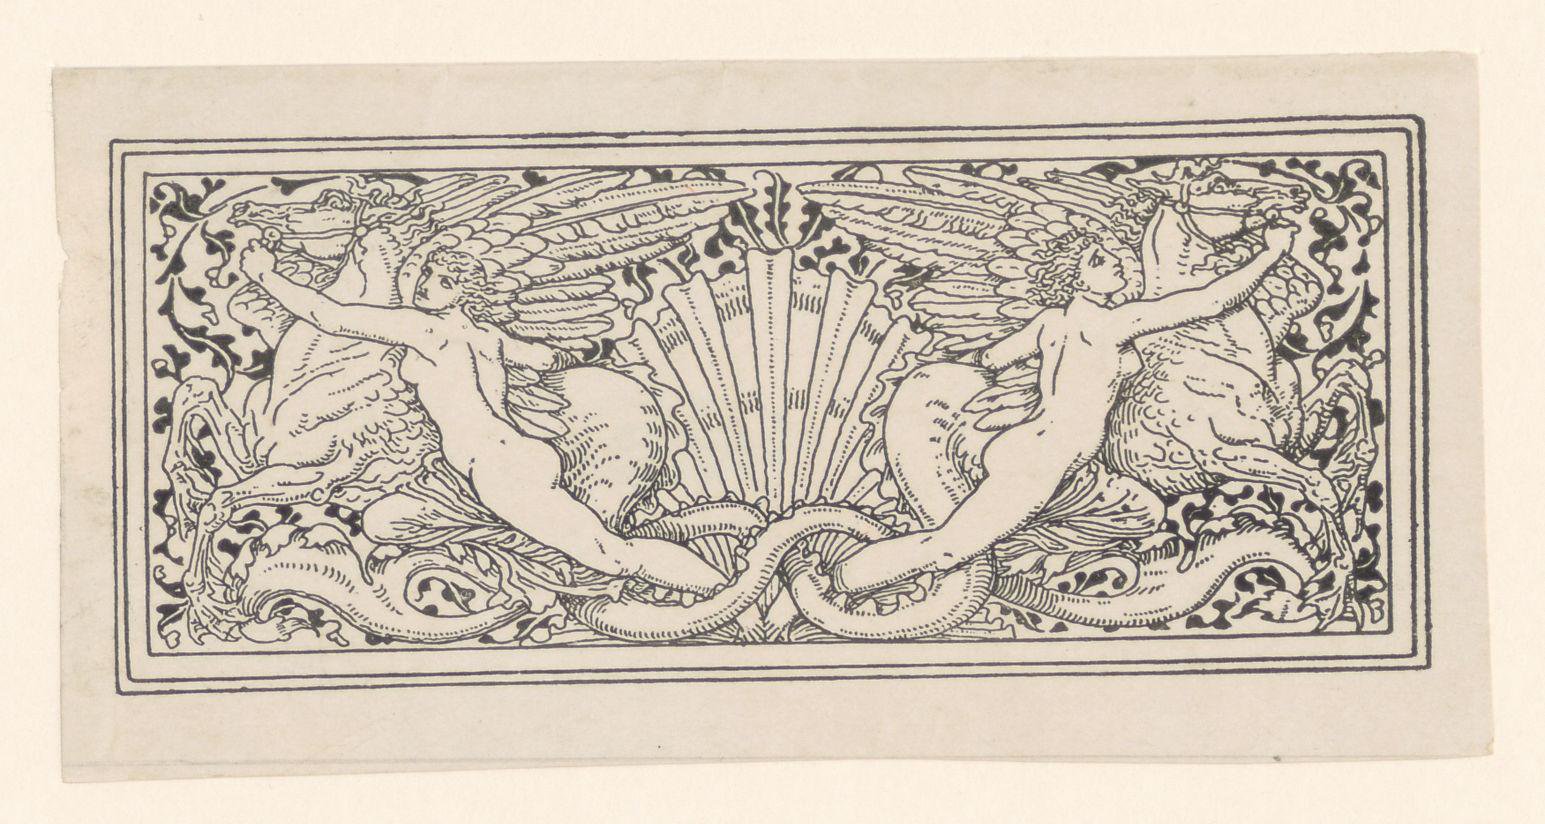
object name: print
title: Twee figuren met hippocampus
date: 1887-1893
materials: paper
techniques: engraving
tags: adult man (+ two persons), sea-horse, hippocamp, 'hippocampus', (horse/fish) (mythological hybrid monster)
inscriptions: collector's mark: Lugt 2228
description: De prent is gebruikt in: Crane, Walter. The claims of decorative art. Londen: Lawrence & Bullen, 1892.